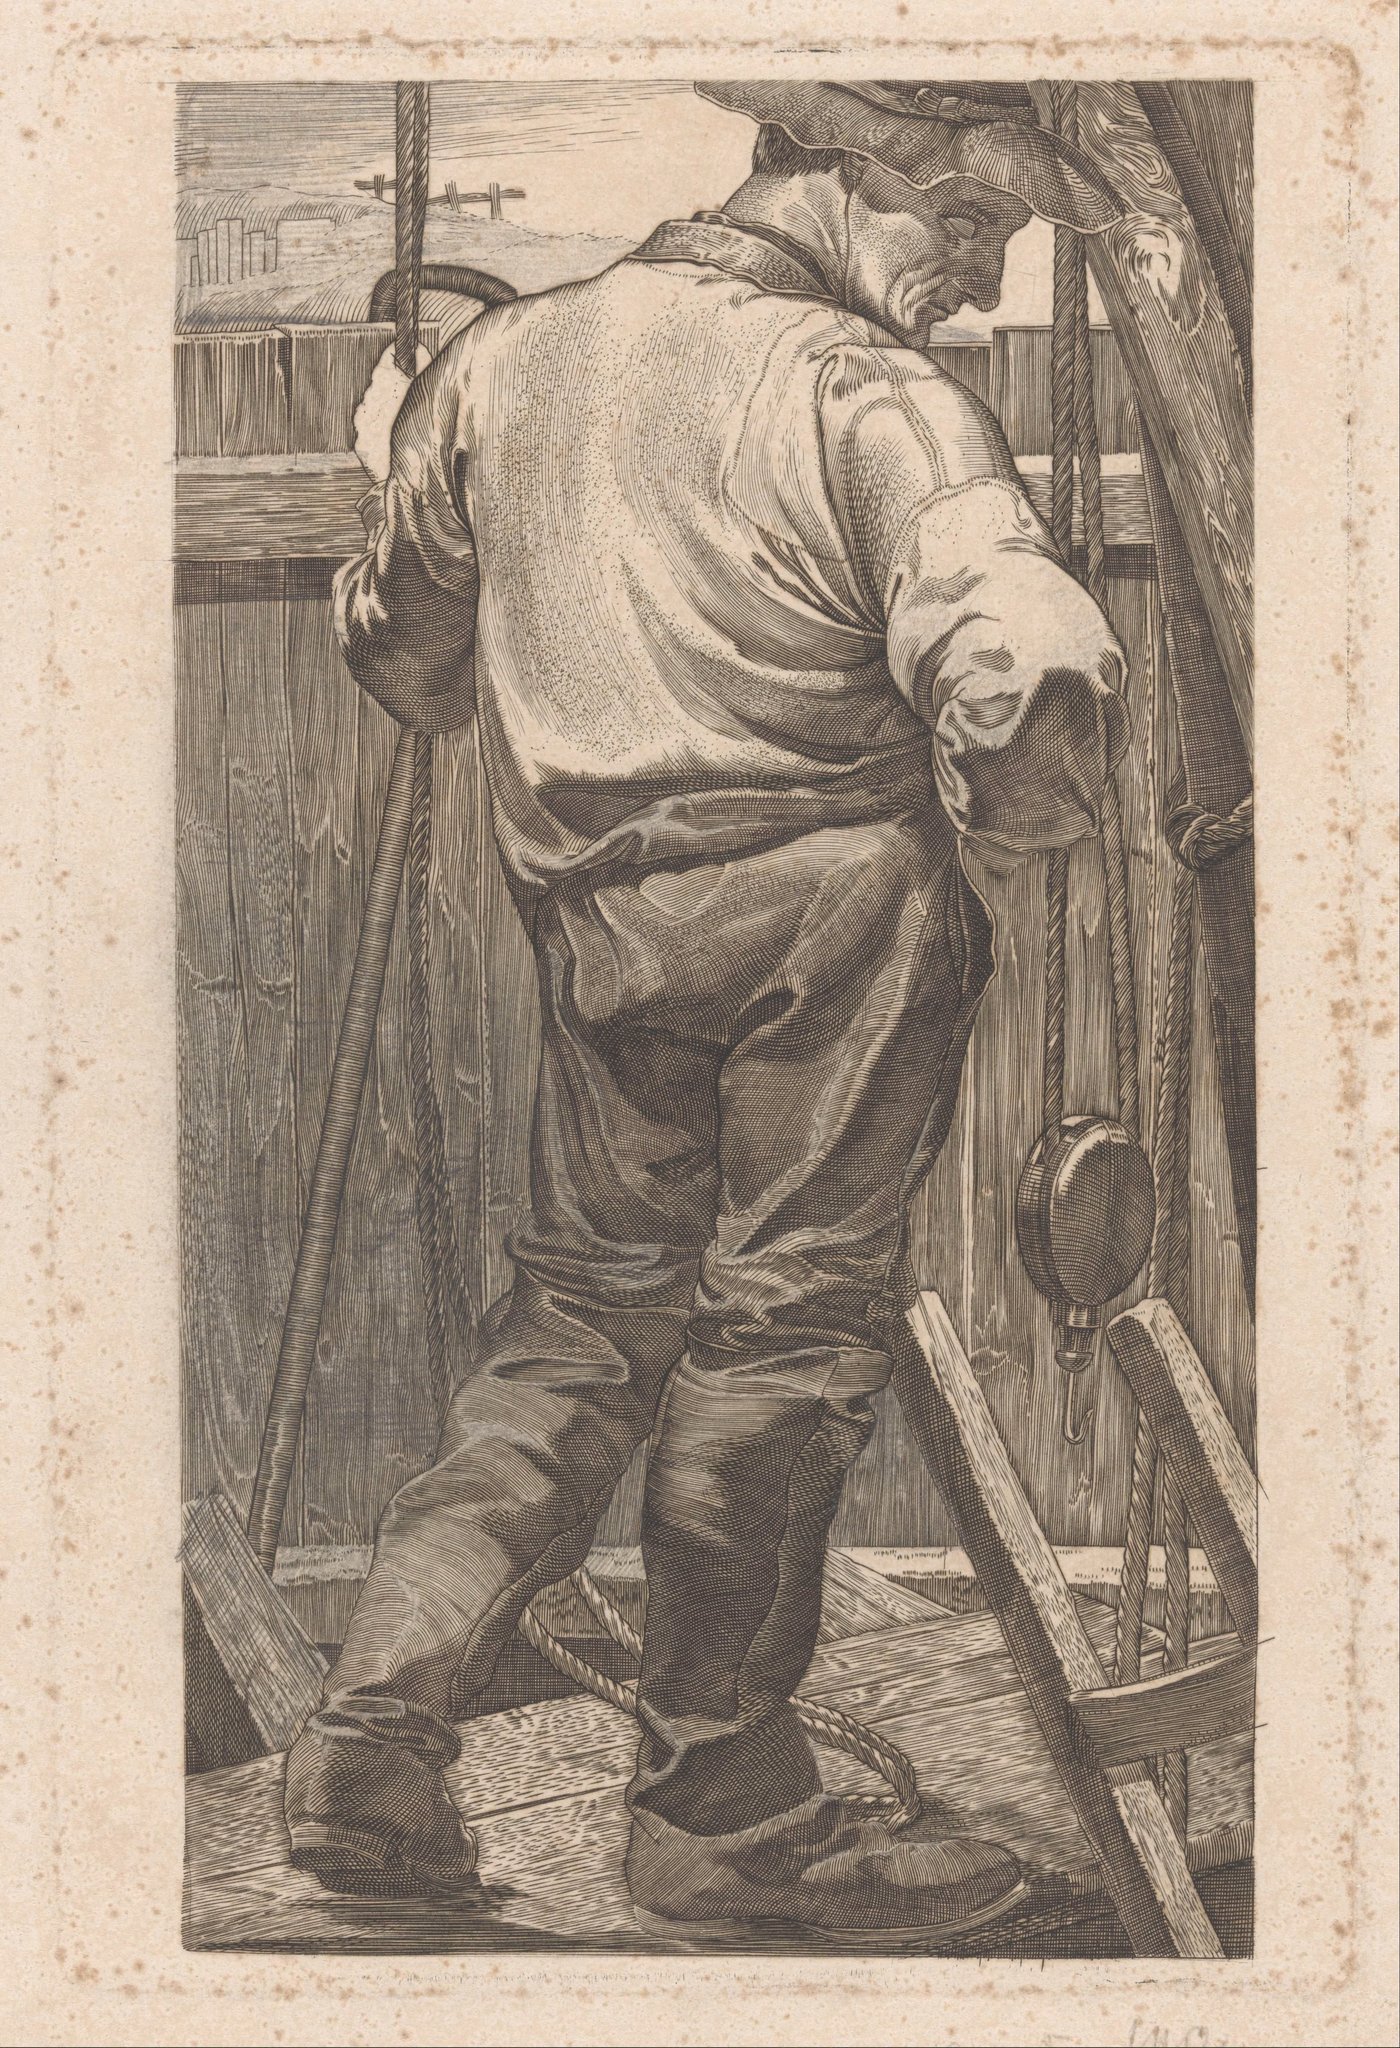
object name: print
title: Arbeider bij een houten hek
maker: johannes josephus aarts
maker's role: draughtsman, print maker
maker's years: 1871-1934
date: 1902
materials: paper, pencil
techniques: engraving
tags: working class, labourers, tools, aids, implements ~ crafts and industries: rope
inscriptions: collector's mark: Lugt 2166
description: Een arbeider met hoed, op de rug gezien, staand voor een houten hek. Rechtsonder de bovenkant van een ladder en een katrol met haak aan een touw.